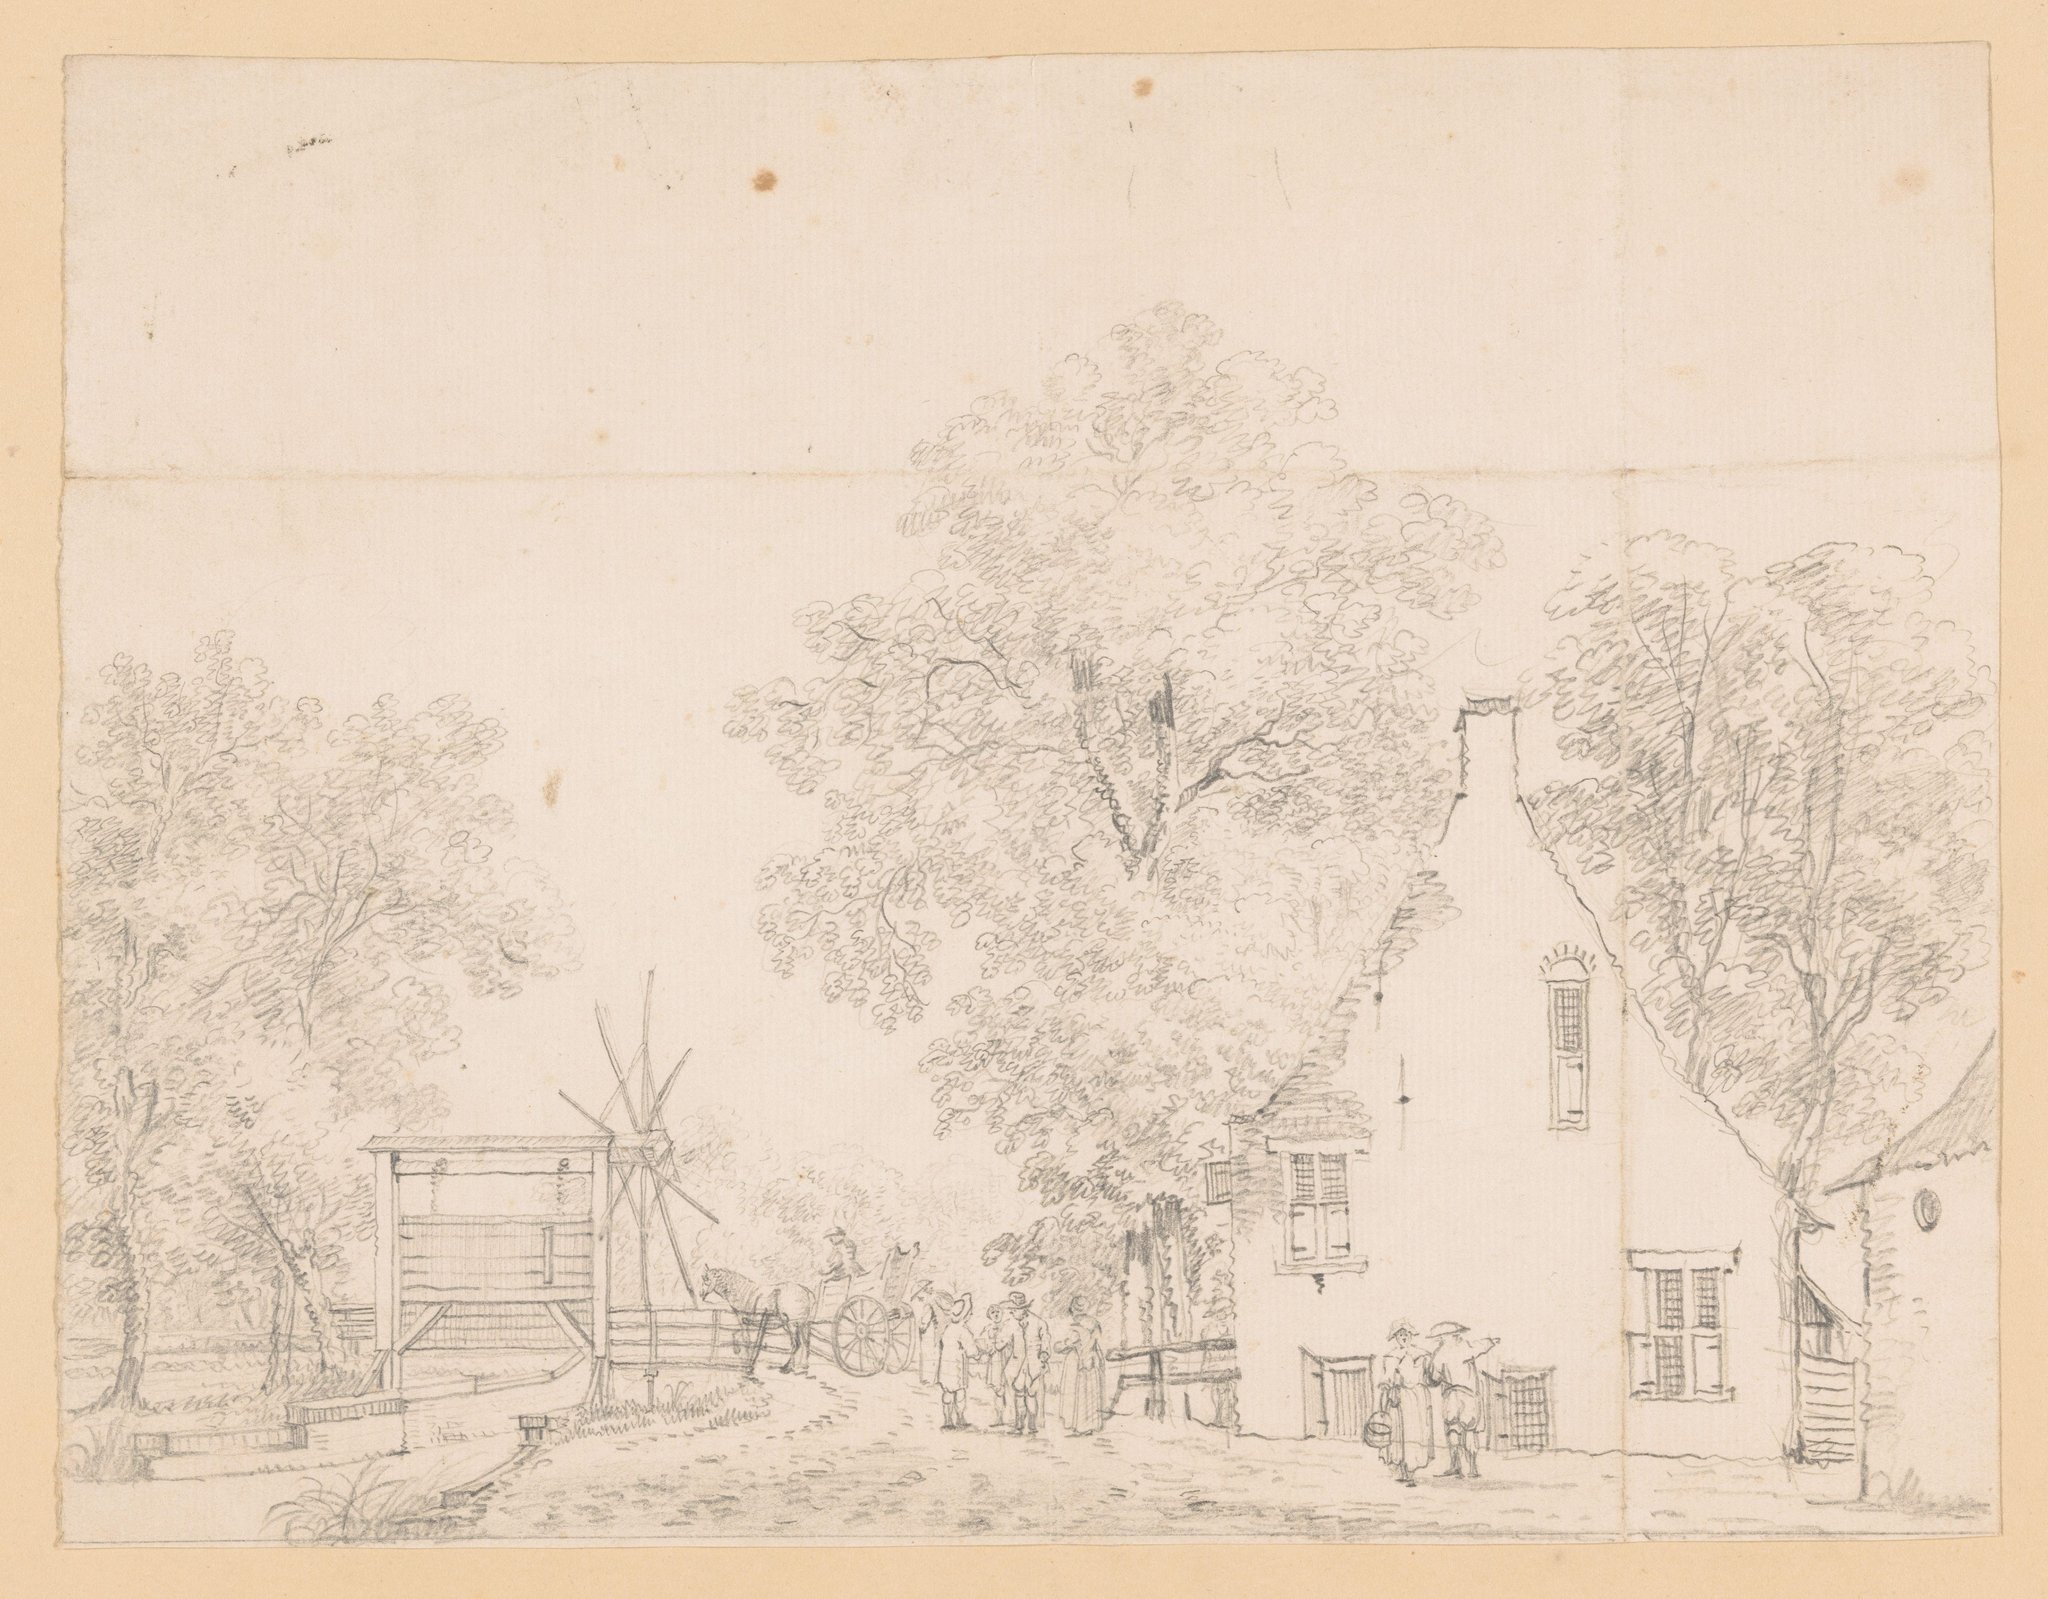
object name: drawing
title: Gezicht op De Klop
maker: Anonymous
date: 1764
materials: paper, pencil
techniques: drawing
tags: bridge in village across river, canal, etc.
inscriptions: collector's mark: Lugt 2228, annotation: ‘De Klop 29 aug 1764’